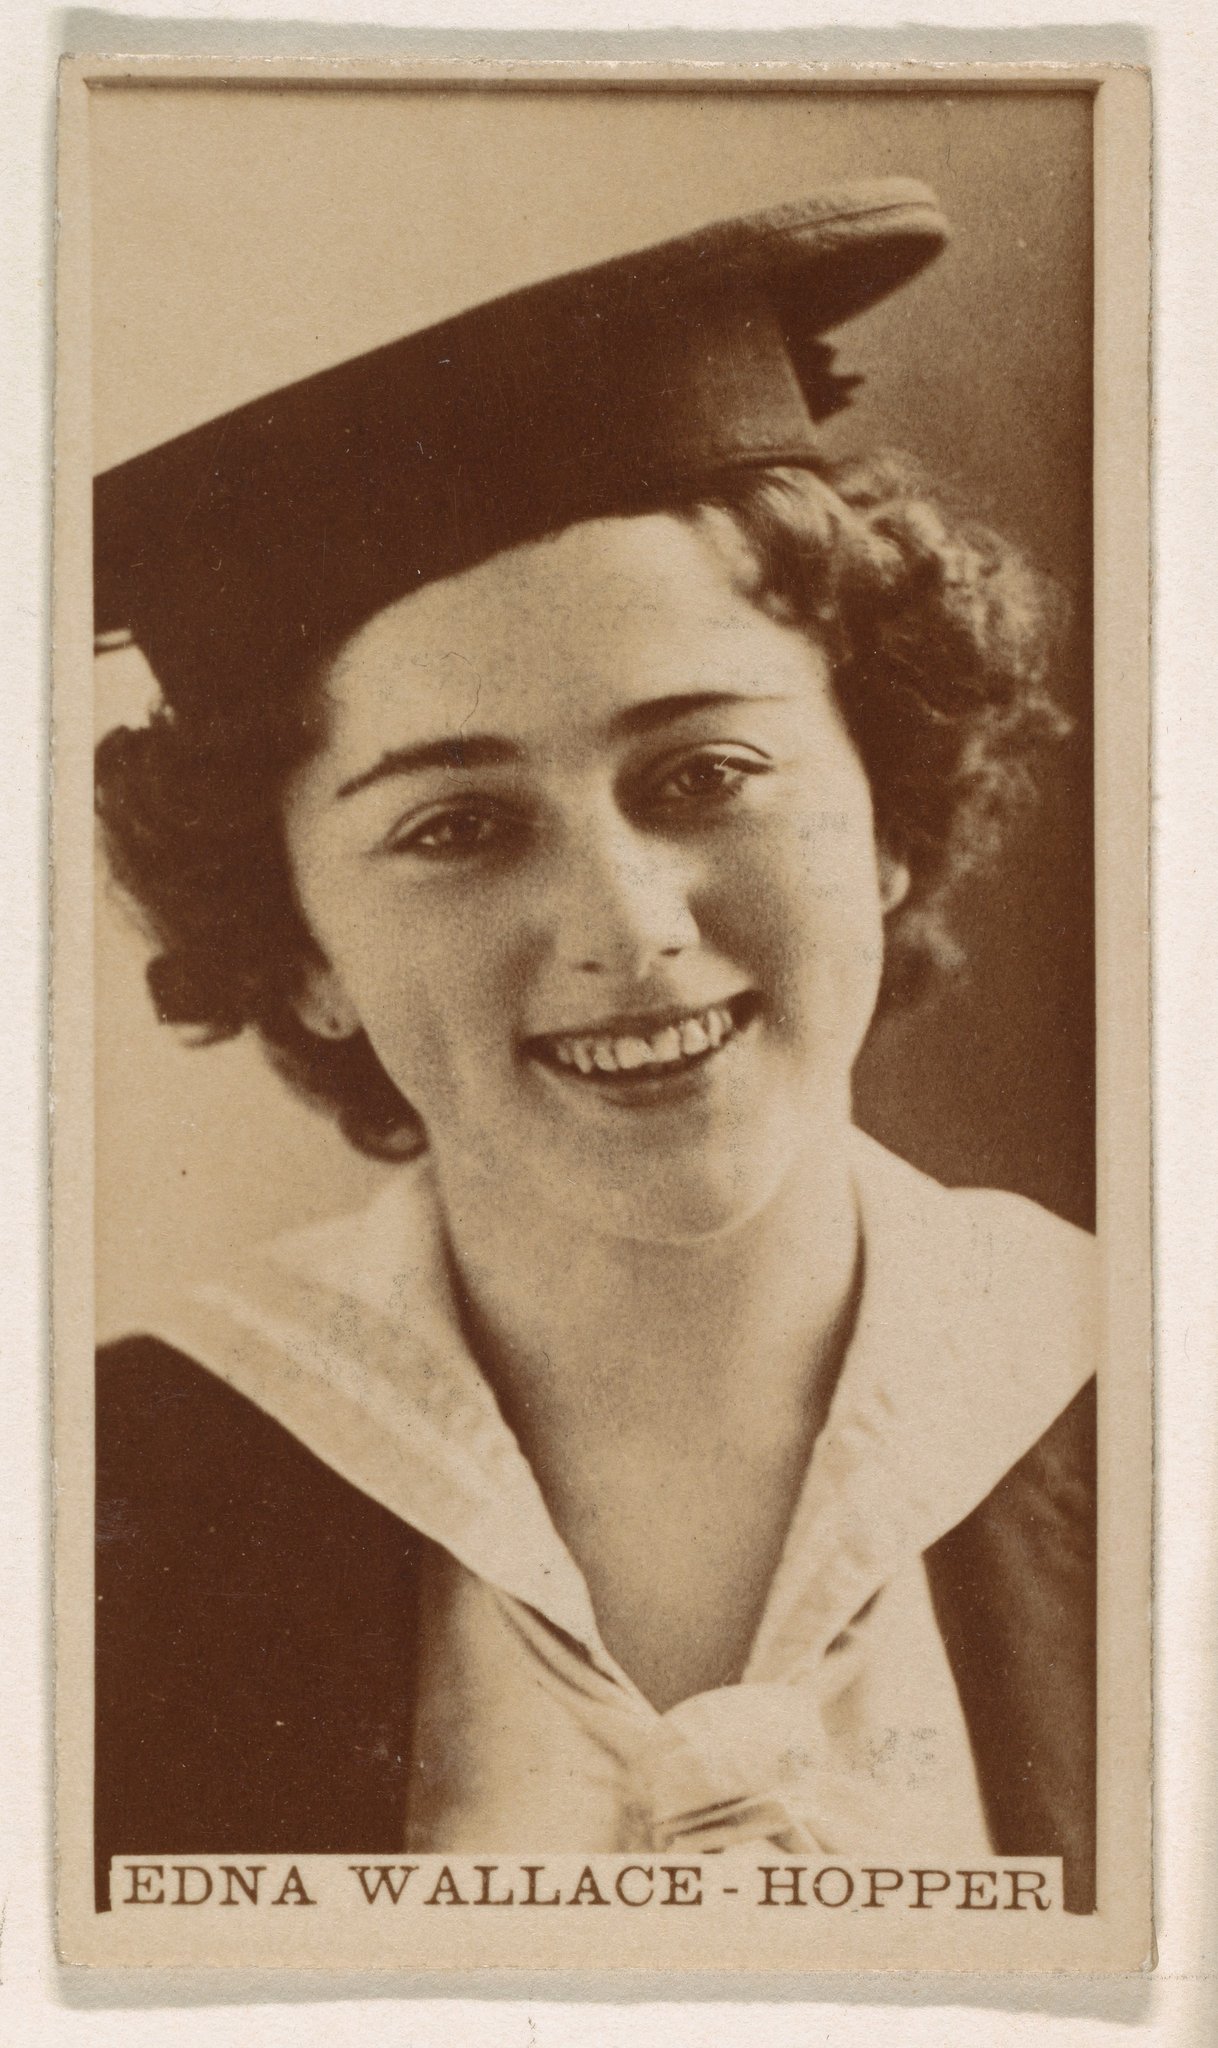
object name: photograph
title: Edna Wallace-Hopper, from the Actresses series (N245) issued by Kinney Brothers to promote Sweet Caporal Cigarettes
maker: kinney brothers tobacco company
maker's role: publisher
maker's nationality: american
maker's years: 1869-2011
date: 1890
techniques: albumen silver print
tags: portraits,women,actresses